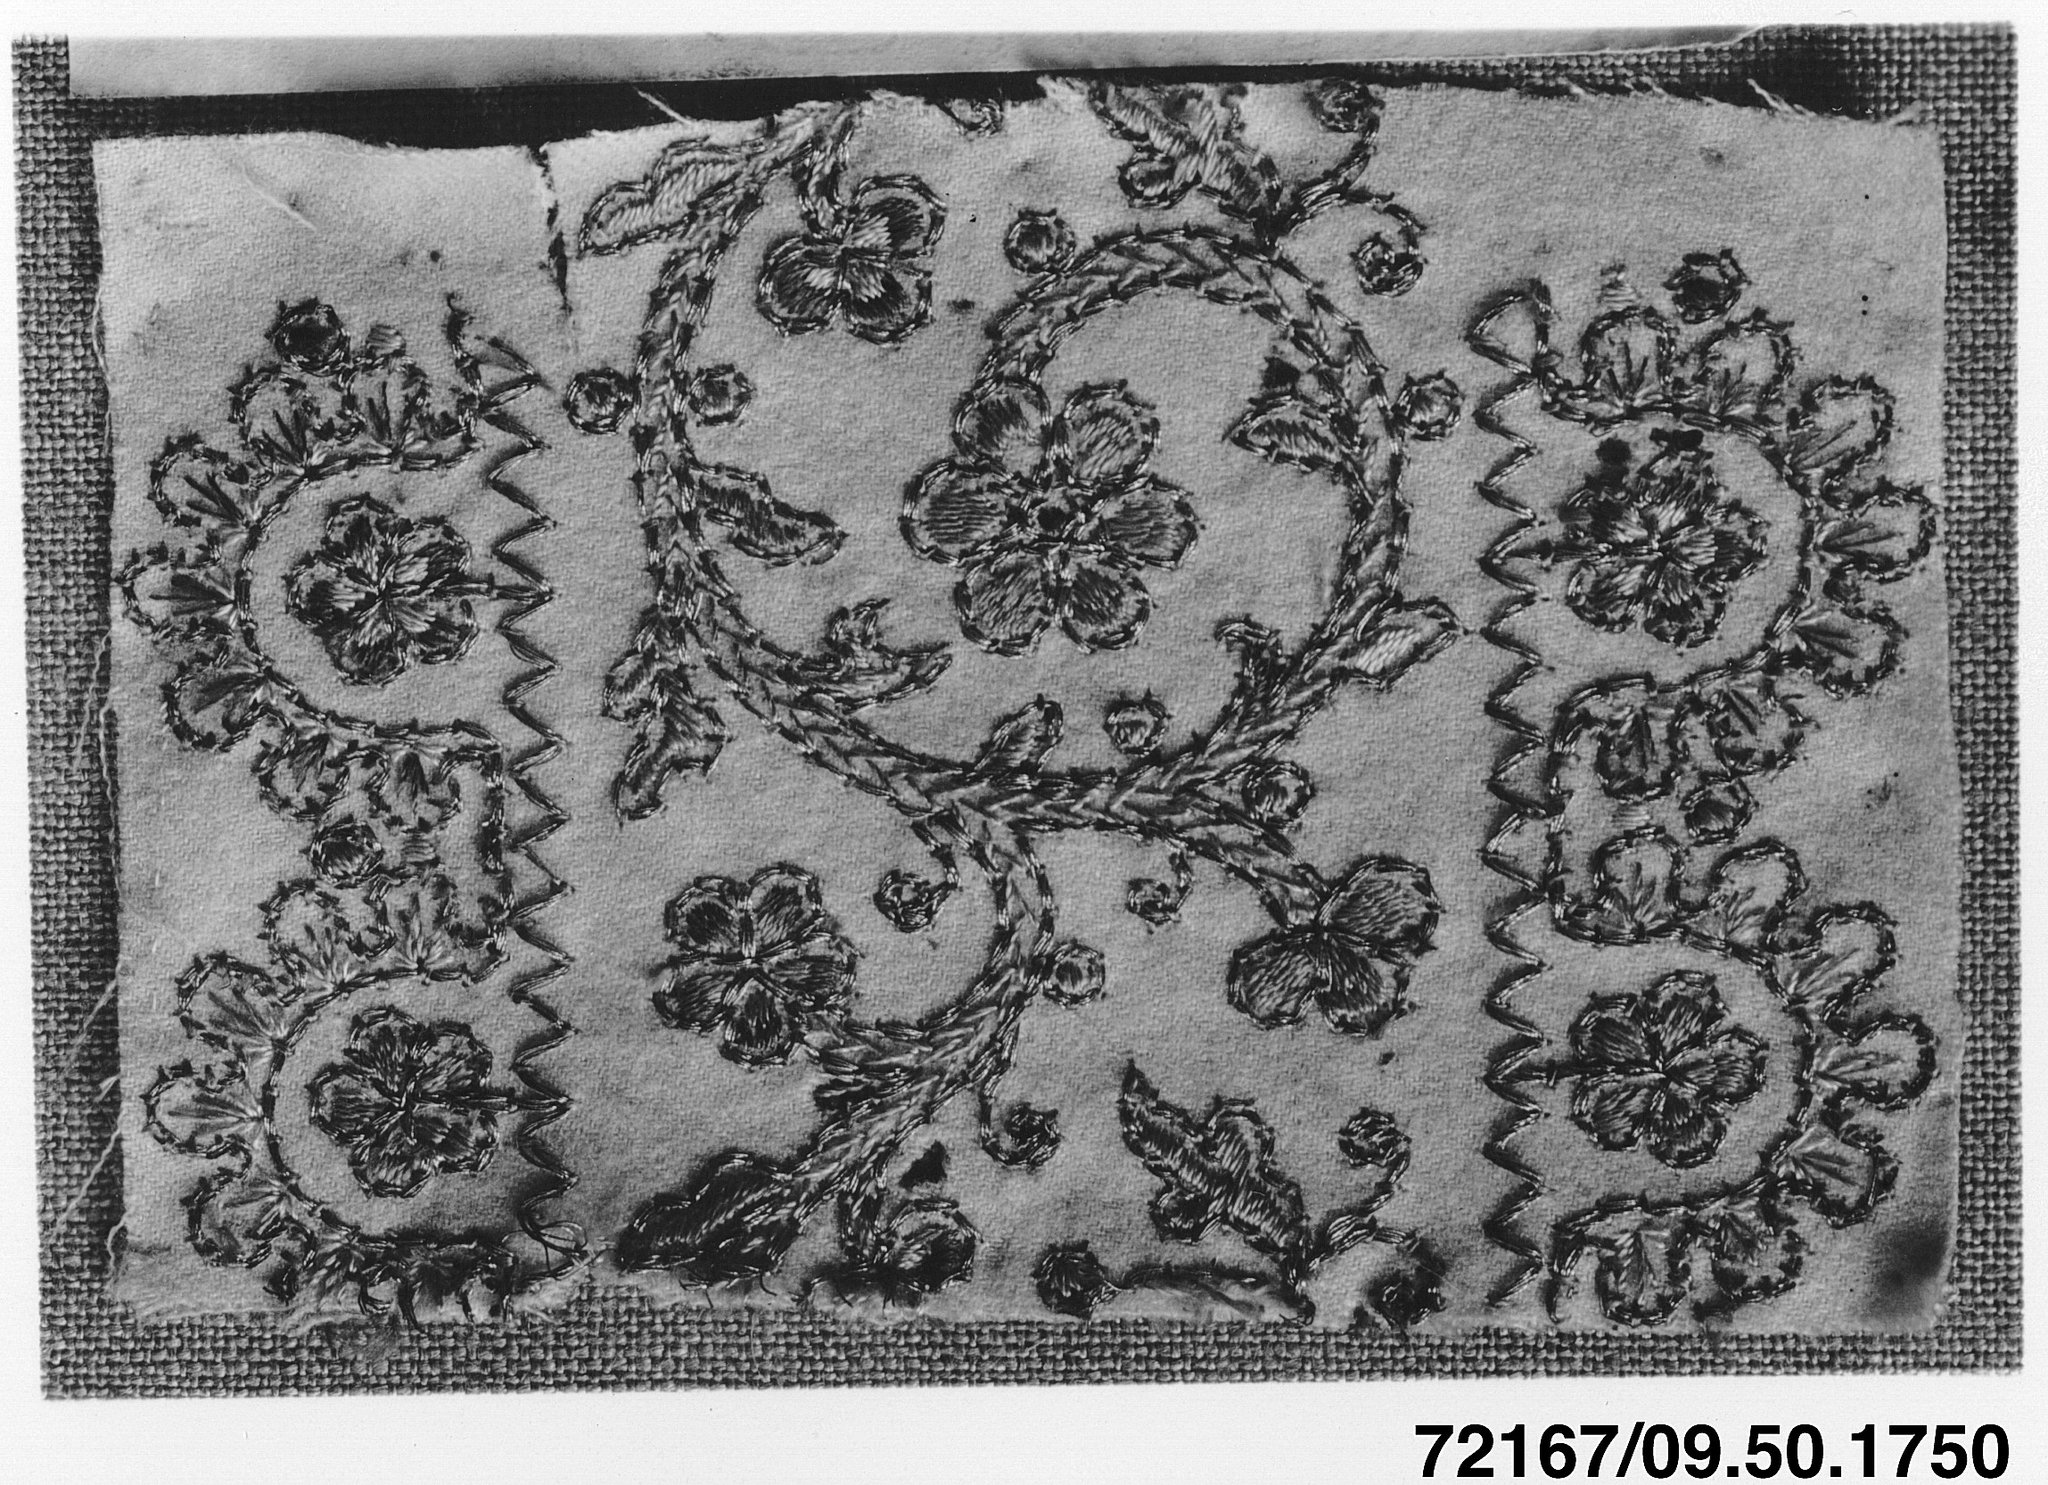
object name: fragment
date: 1801-1900